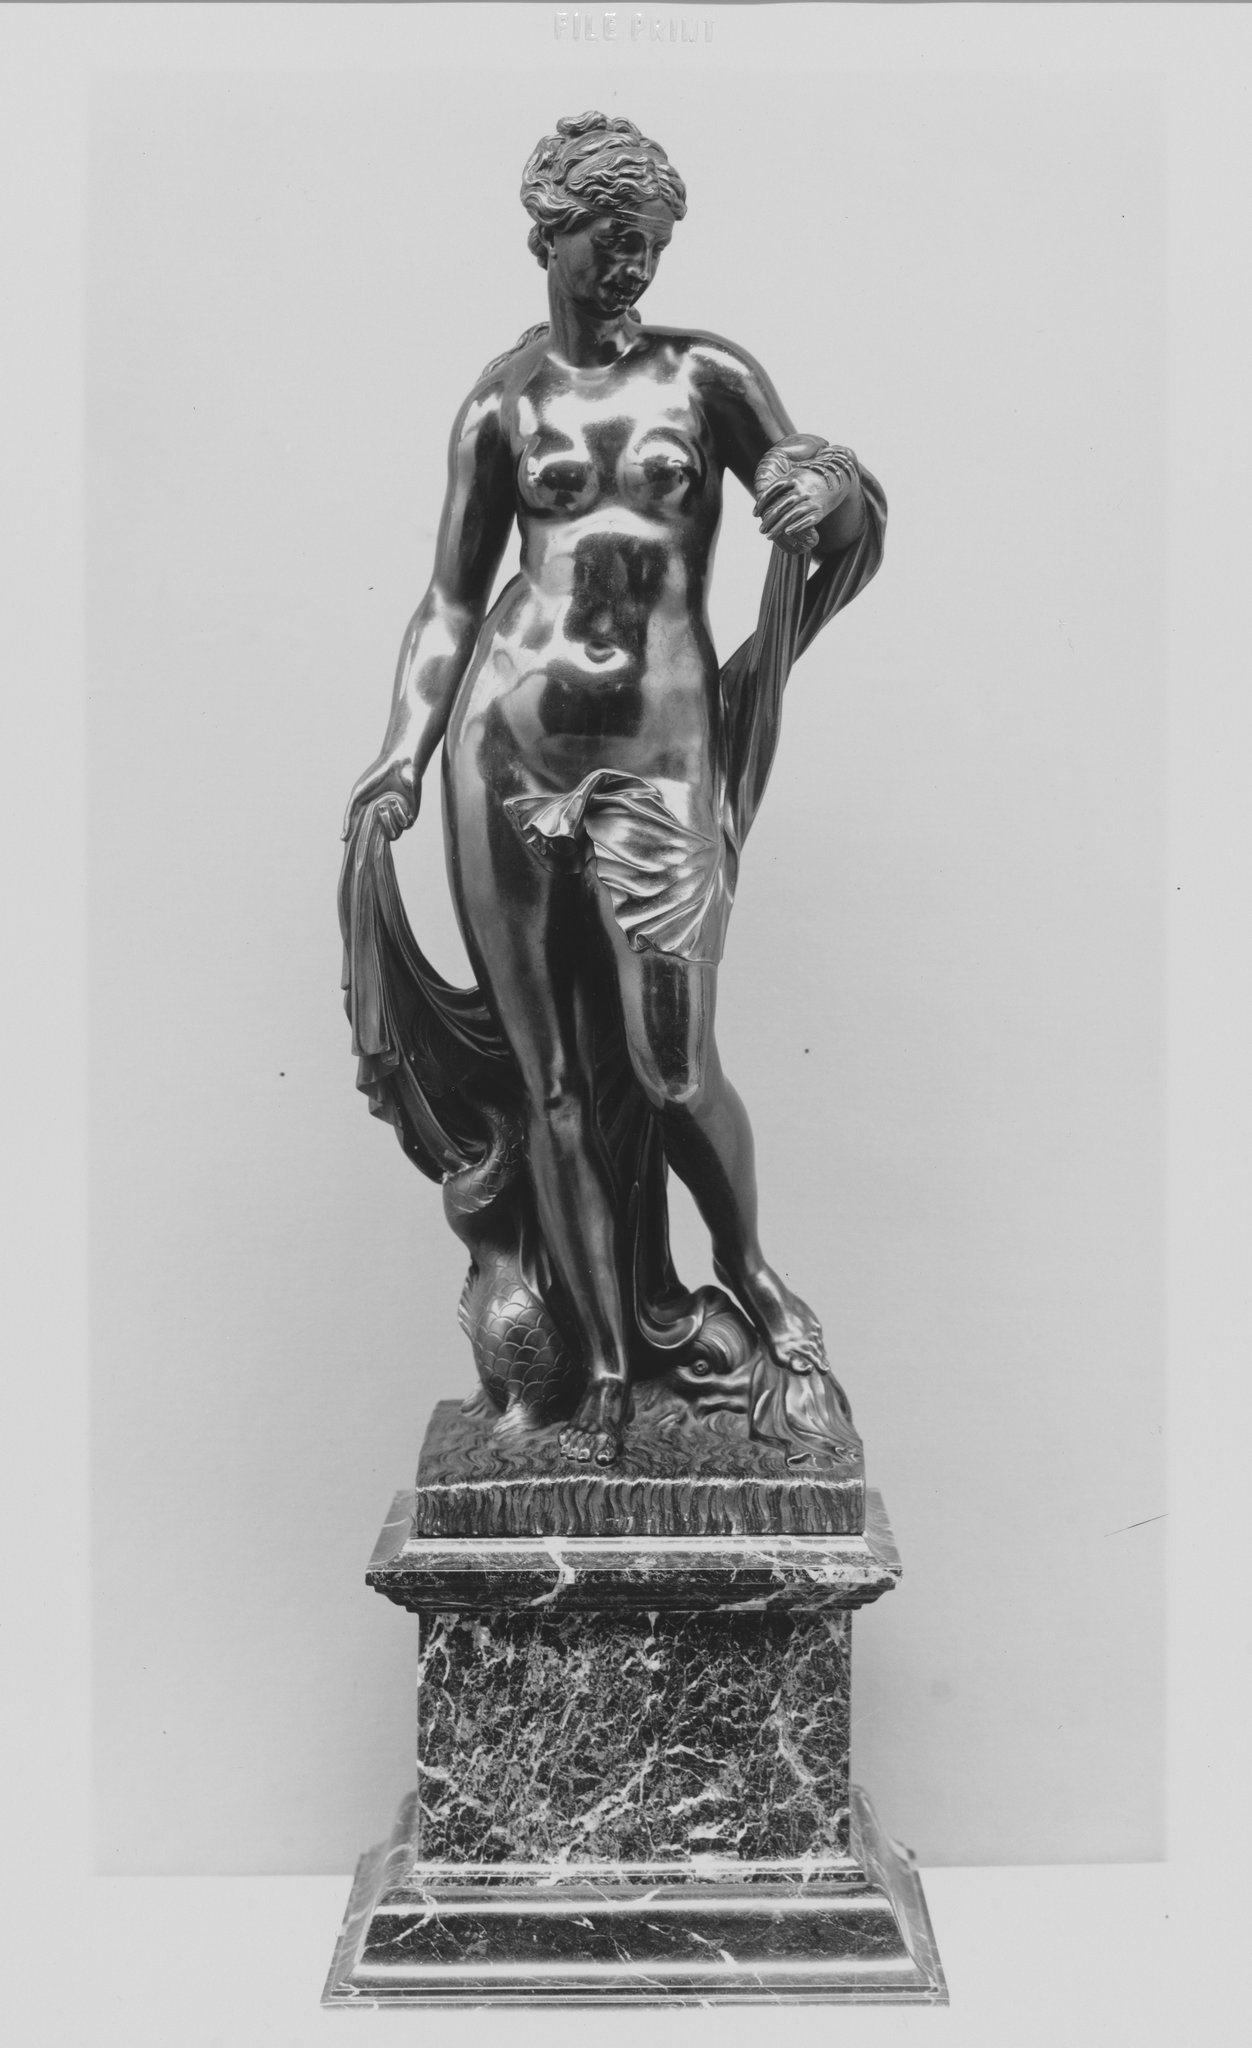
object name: statuette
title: Amphitrite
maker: michel anguier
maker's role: artist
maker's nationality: french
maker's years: 1612-1686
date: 1701-1900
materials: bronze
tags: female nudes